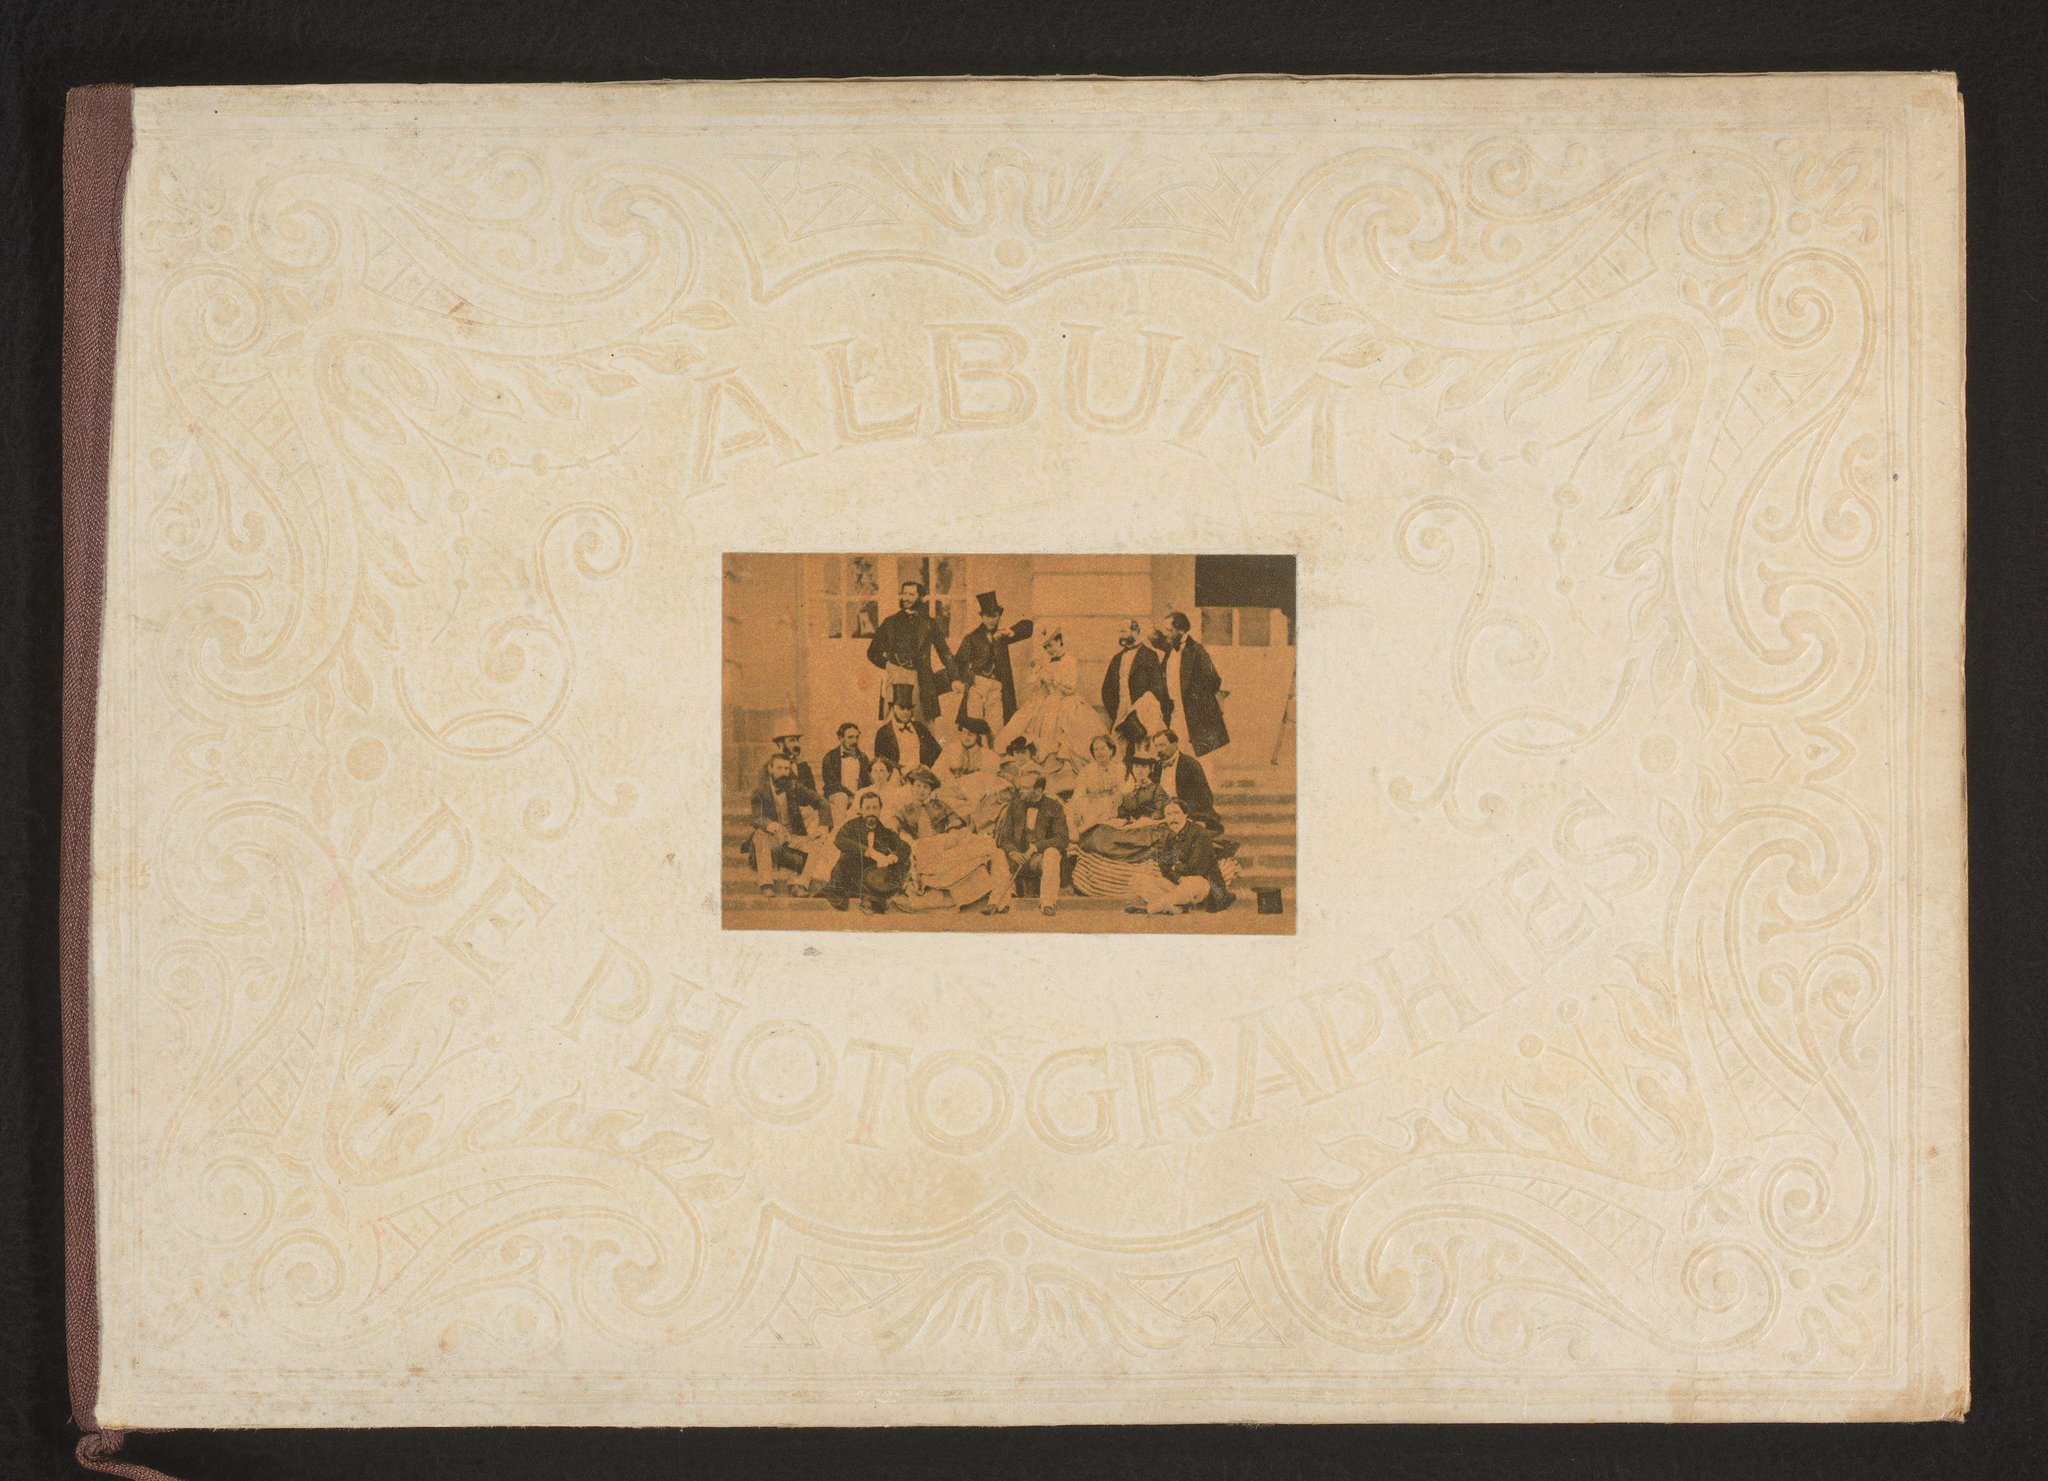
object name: photograph album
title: Album de photographies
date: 1845-1900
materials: cardboard, paper, photographic support, textile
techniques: lithograph, rotogravure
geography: brussels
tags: caserta, alfred de musset, maria carolina van bourbon-sicilië, abel niépce de saint-victor, sevilla, london, napoleon iii (keizer der fransen), politician, brussels, painter, print maker, draughtsman, camille corot, louis jacques mandé daguerre, honoré de balzac, paul verlaine, victor hugo, george sand, marseille, frans van orléans (prins van joinville), théophile gautier, hector berlioz, lodewijk filips i (koning van frankrijk), portrait of actor, actress, writer, poet, author, science and technology (+ portrait of scholar, scientist), artist (in general), france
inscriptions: inscription: ‘A mon petit fils/ (...)’, number: ‘N. d'autorisation 19.321’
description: Plakboek met 35 portretten van bekende Franse wetenschappers, kunstenaars, auteurs, theatermakers, politici, regeringsleiders en geestelijken verdeeld over 12 bladen, samengesteld door Pierre-Marie Lizerolles en opgedragen aan zijn kleinzoon, J.M. Dufrénoy. Deel 1. Op het voorplat een rotogravure van een groepsportret.